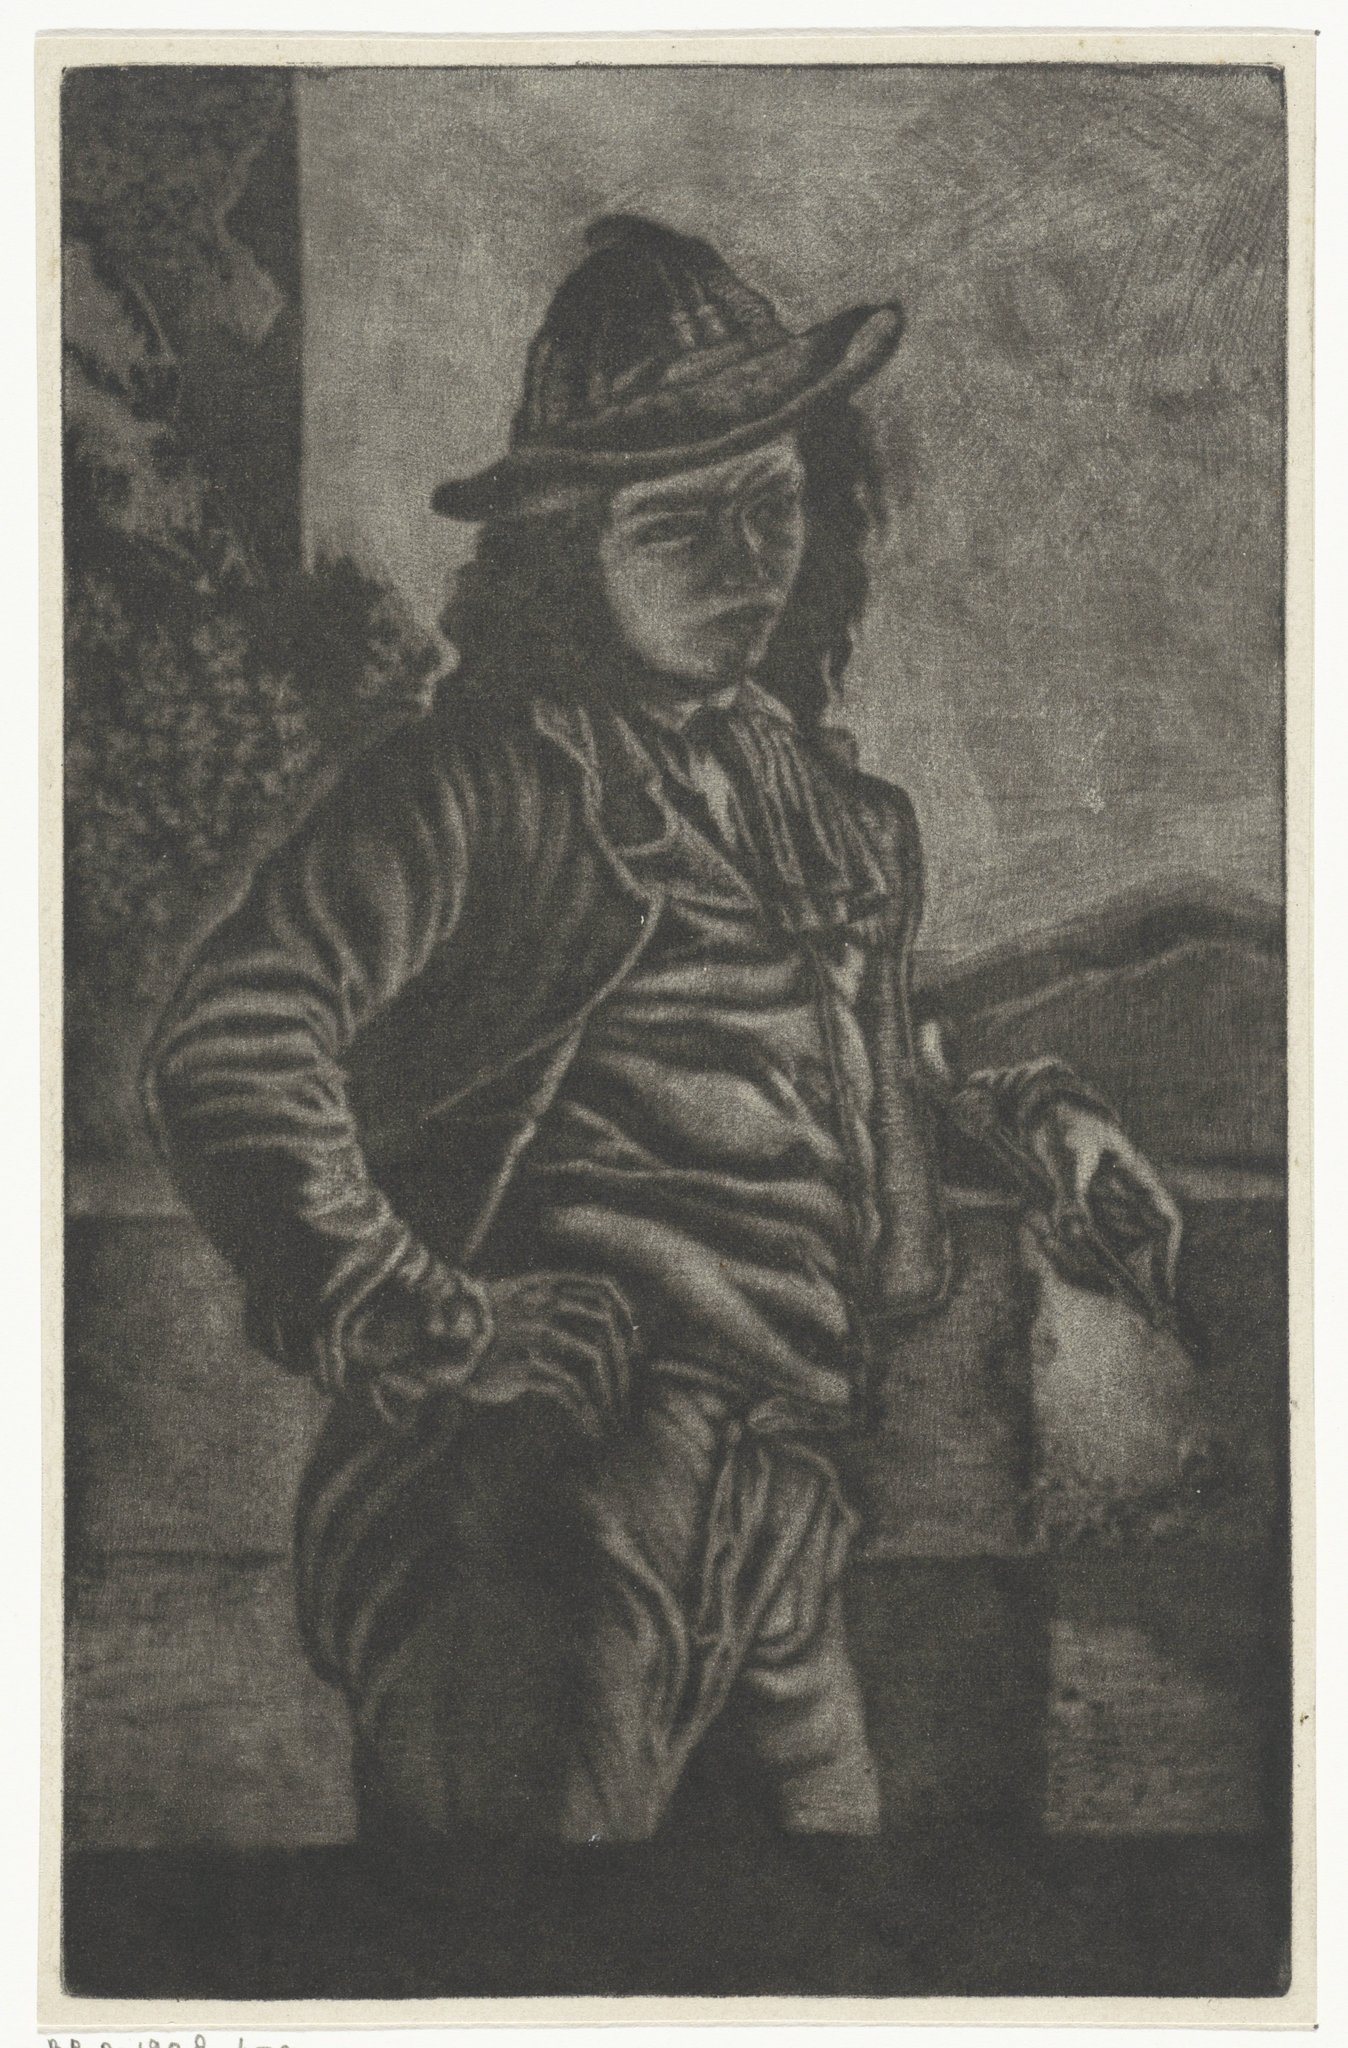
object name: print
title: Staande jongen met een fluit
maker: eberhard cornelis rahms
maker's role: print maker, publisher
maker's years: 1823-1907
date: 1854-1907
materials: paper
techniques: mezzotint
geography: netherlands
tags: (high) hill, head-gear: hat (+ men's clothes), flute, aulos, tibia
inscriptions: collector's mark: Lugt 2228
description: Een jongen met een fluit in de hand leunt tegen een halfhoge muur. Op de achtergrond een heuvellandschap.